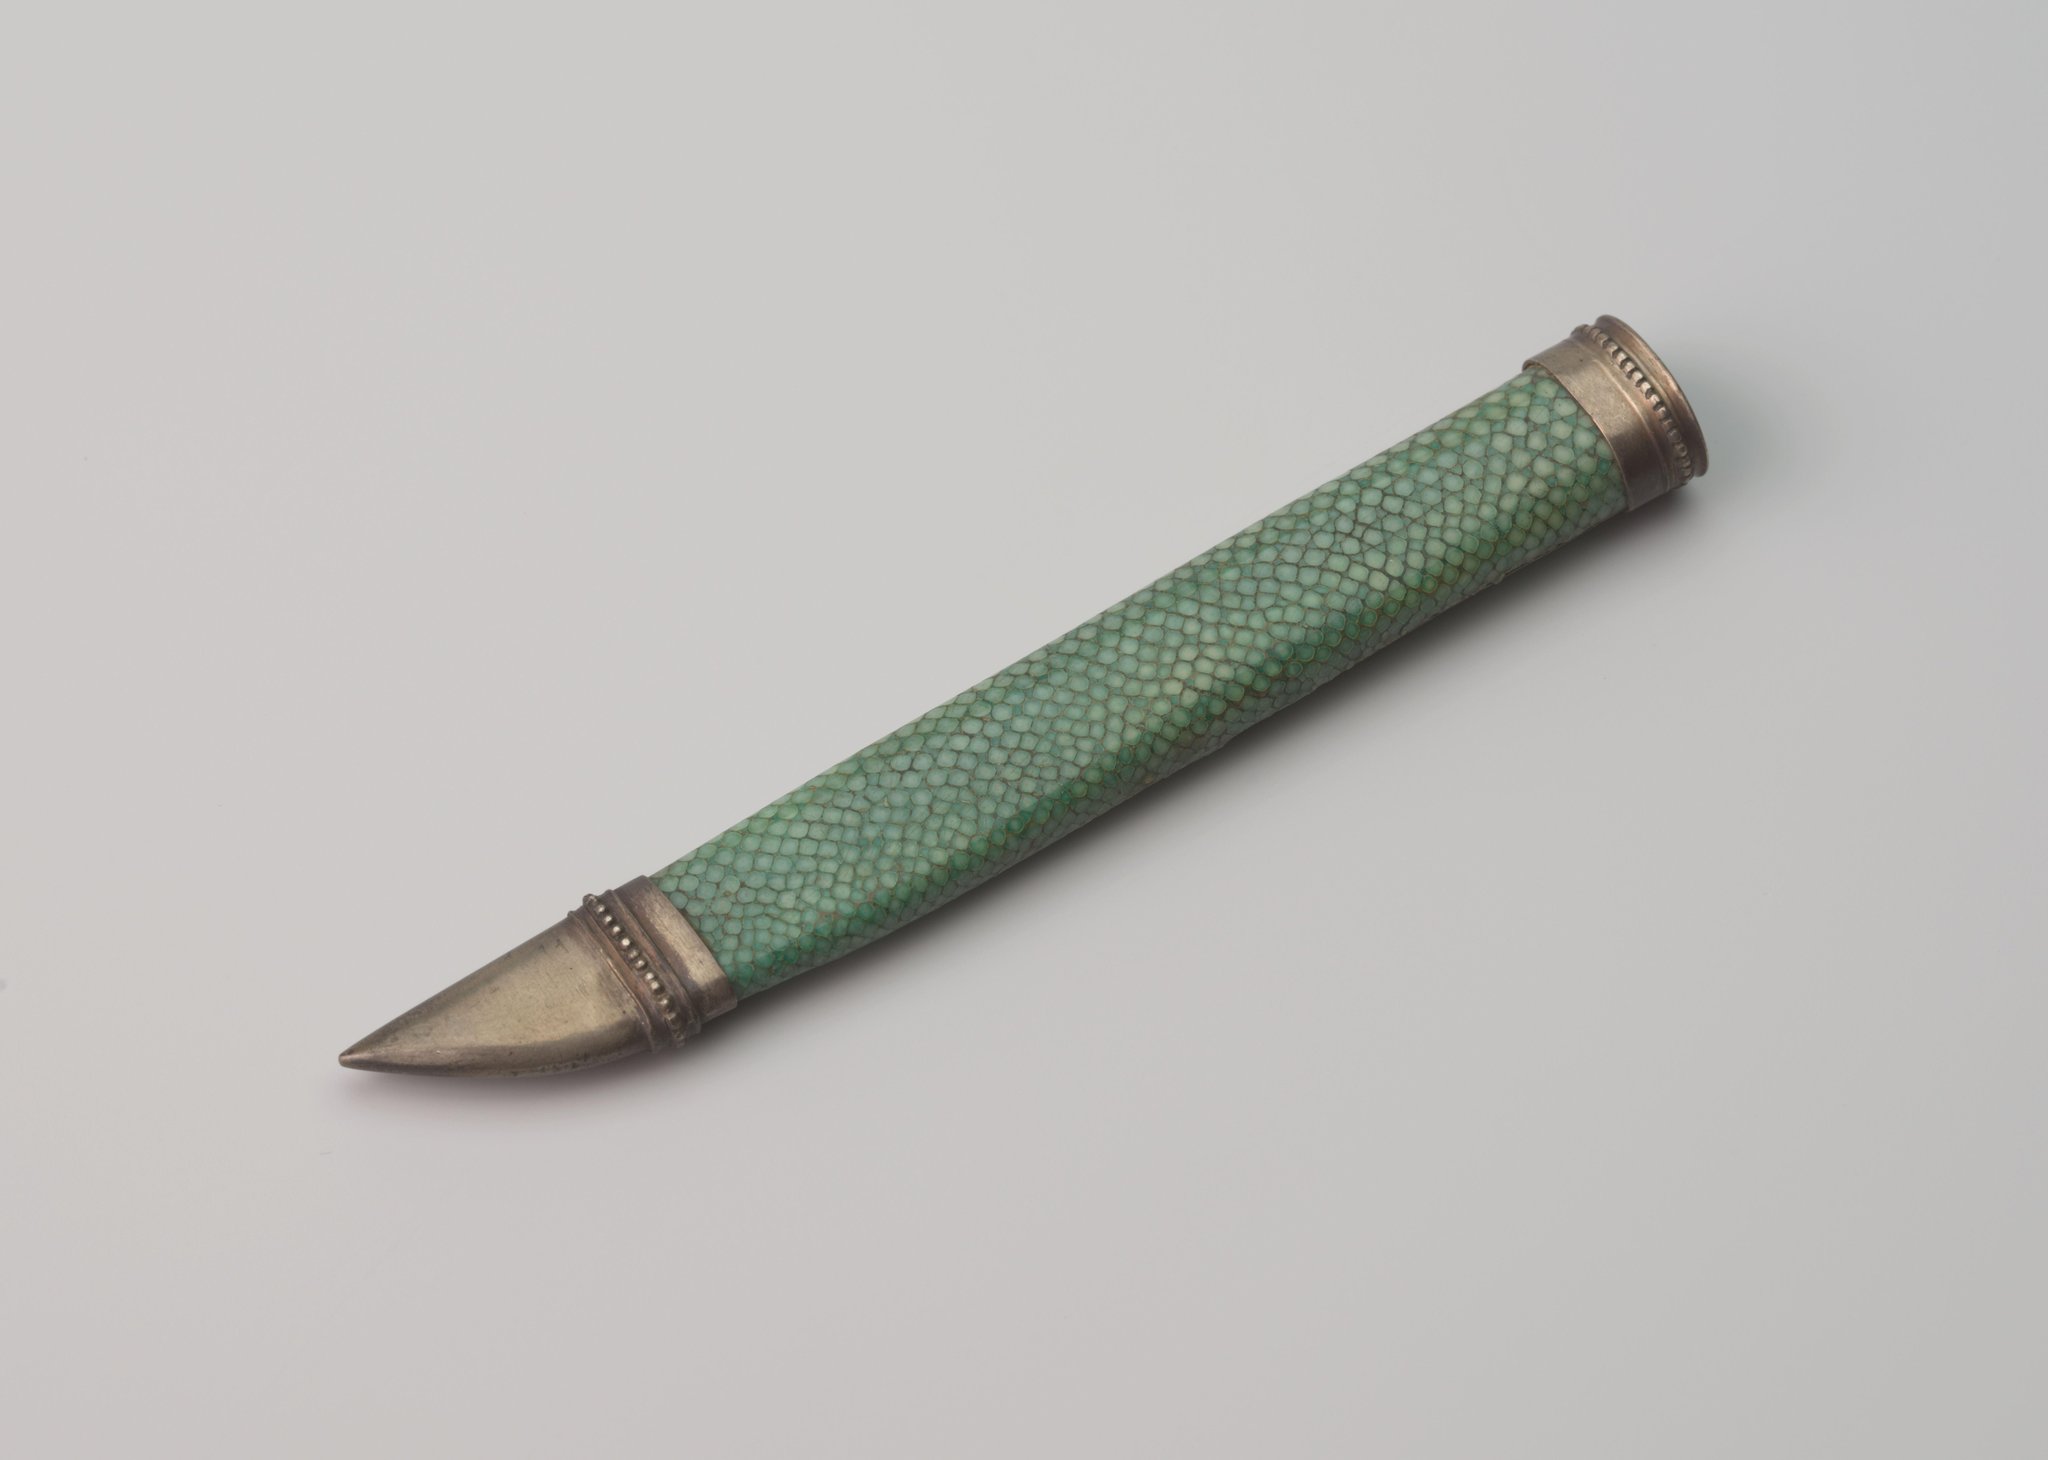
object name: knife with sheath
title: Messchede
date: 1600-1625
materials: skin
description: Messchede met groen gekleurde robbenvel (roggevel) bekleed en met zilver gemonteerd.